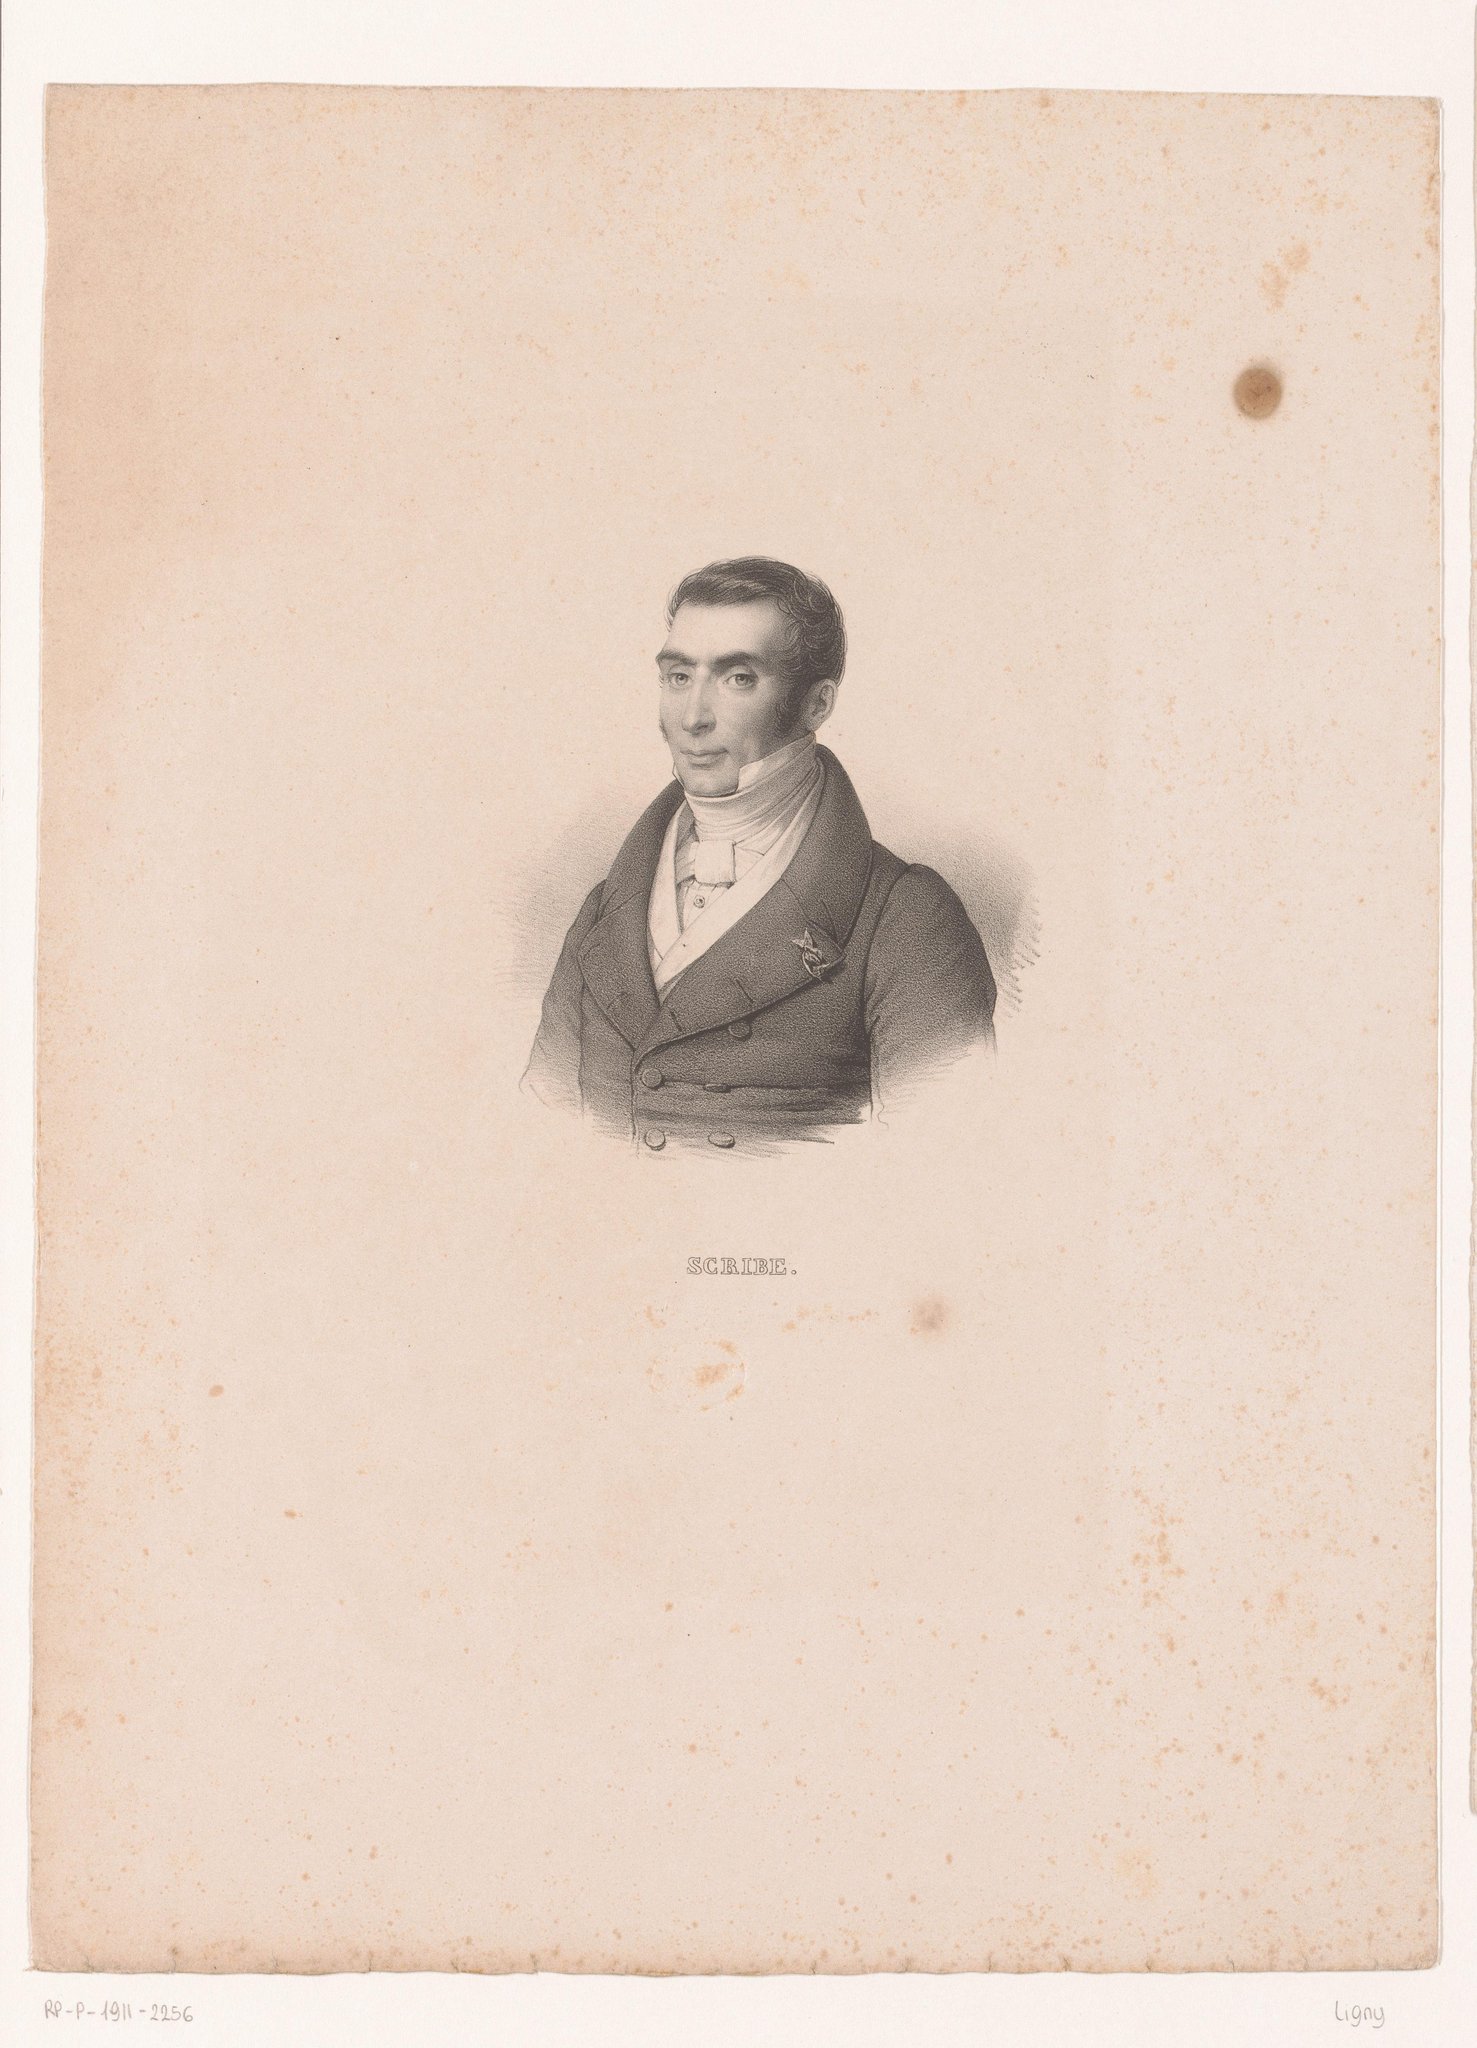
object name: print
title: Scribe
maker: Anonymous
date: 1830-1853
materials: paper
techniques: lithograph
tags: historical persons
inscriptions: collector's mark: Lugt 2228, check stamp: Lugt 4733